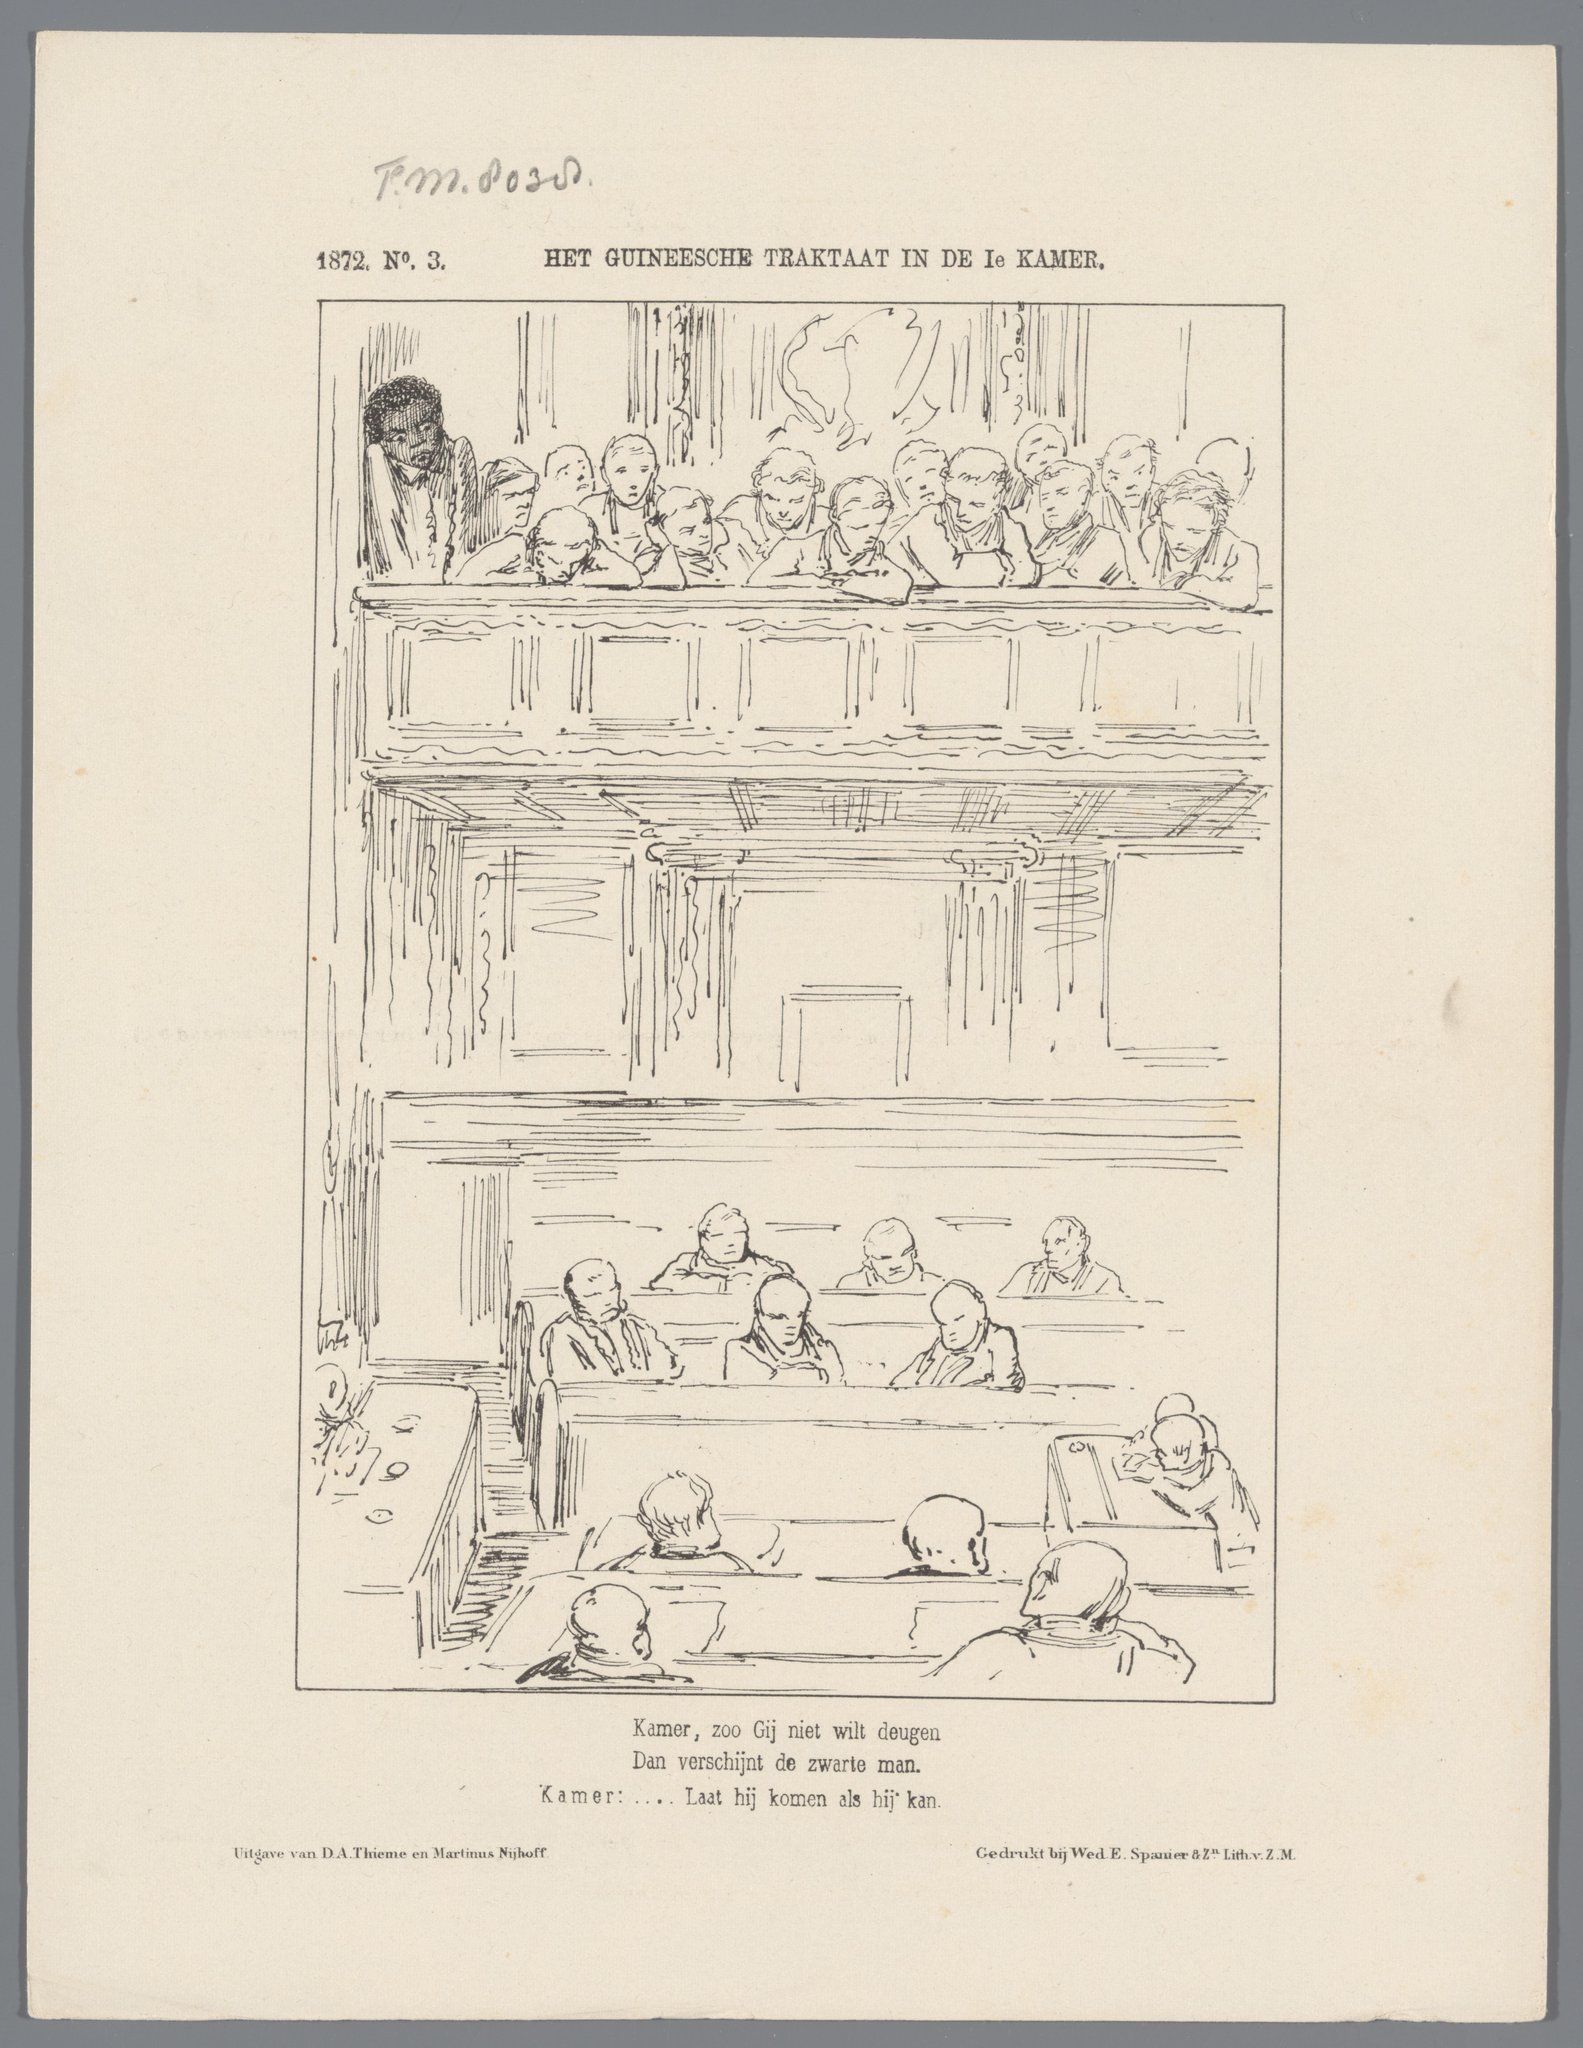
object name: print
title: Het Guineesche traktaat in de Ie Kamer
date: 1872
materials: paper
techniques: lithograph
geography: the hague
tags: eerste kamer der staten-generaal, david mill graves, elmina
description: Spotprent nav de komst van David Mill Graves (de gezant van Elmina) naar Nederland om te protesteren tegen de overdracht aan Engeland tijdens de behandeling van het traktaat tot afstand van de Goudkust in de Eerste Kamer. Vanaf het balkon volgt een zwarte Afrikaan de handelingen. Plaat verschenen bij het weekblad De Nederlandsche Spectator, nr. 3, 1872.